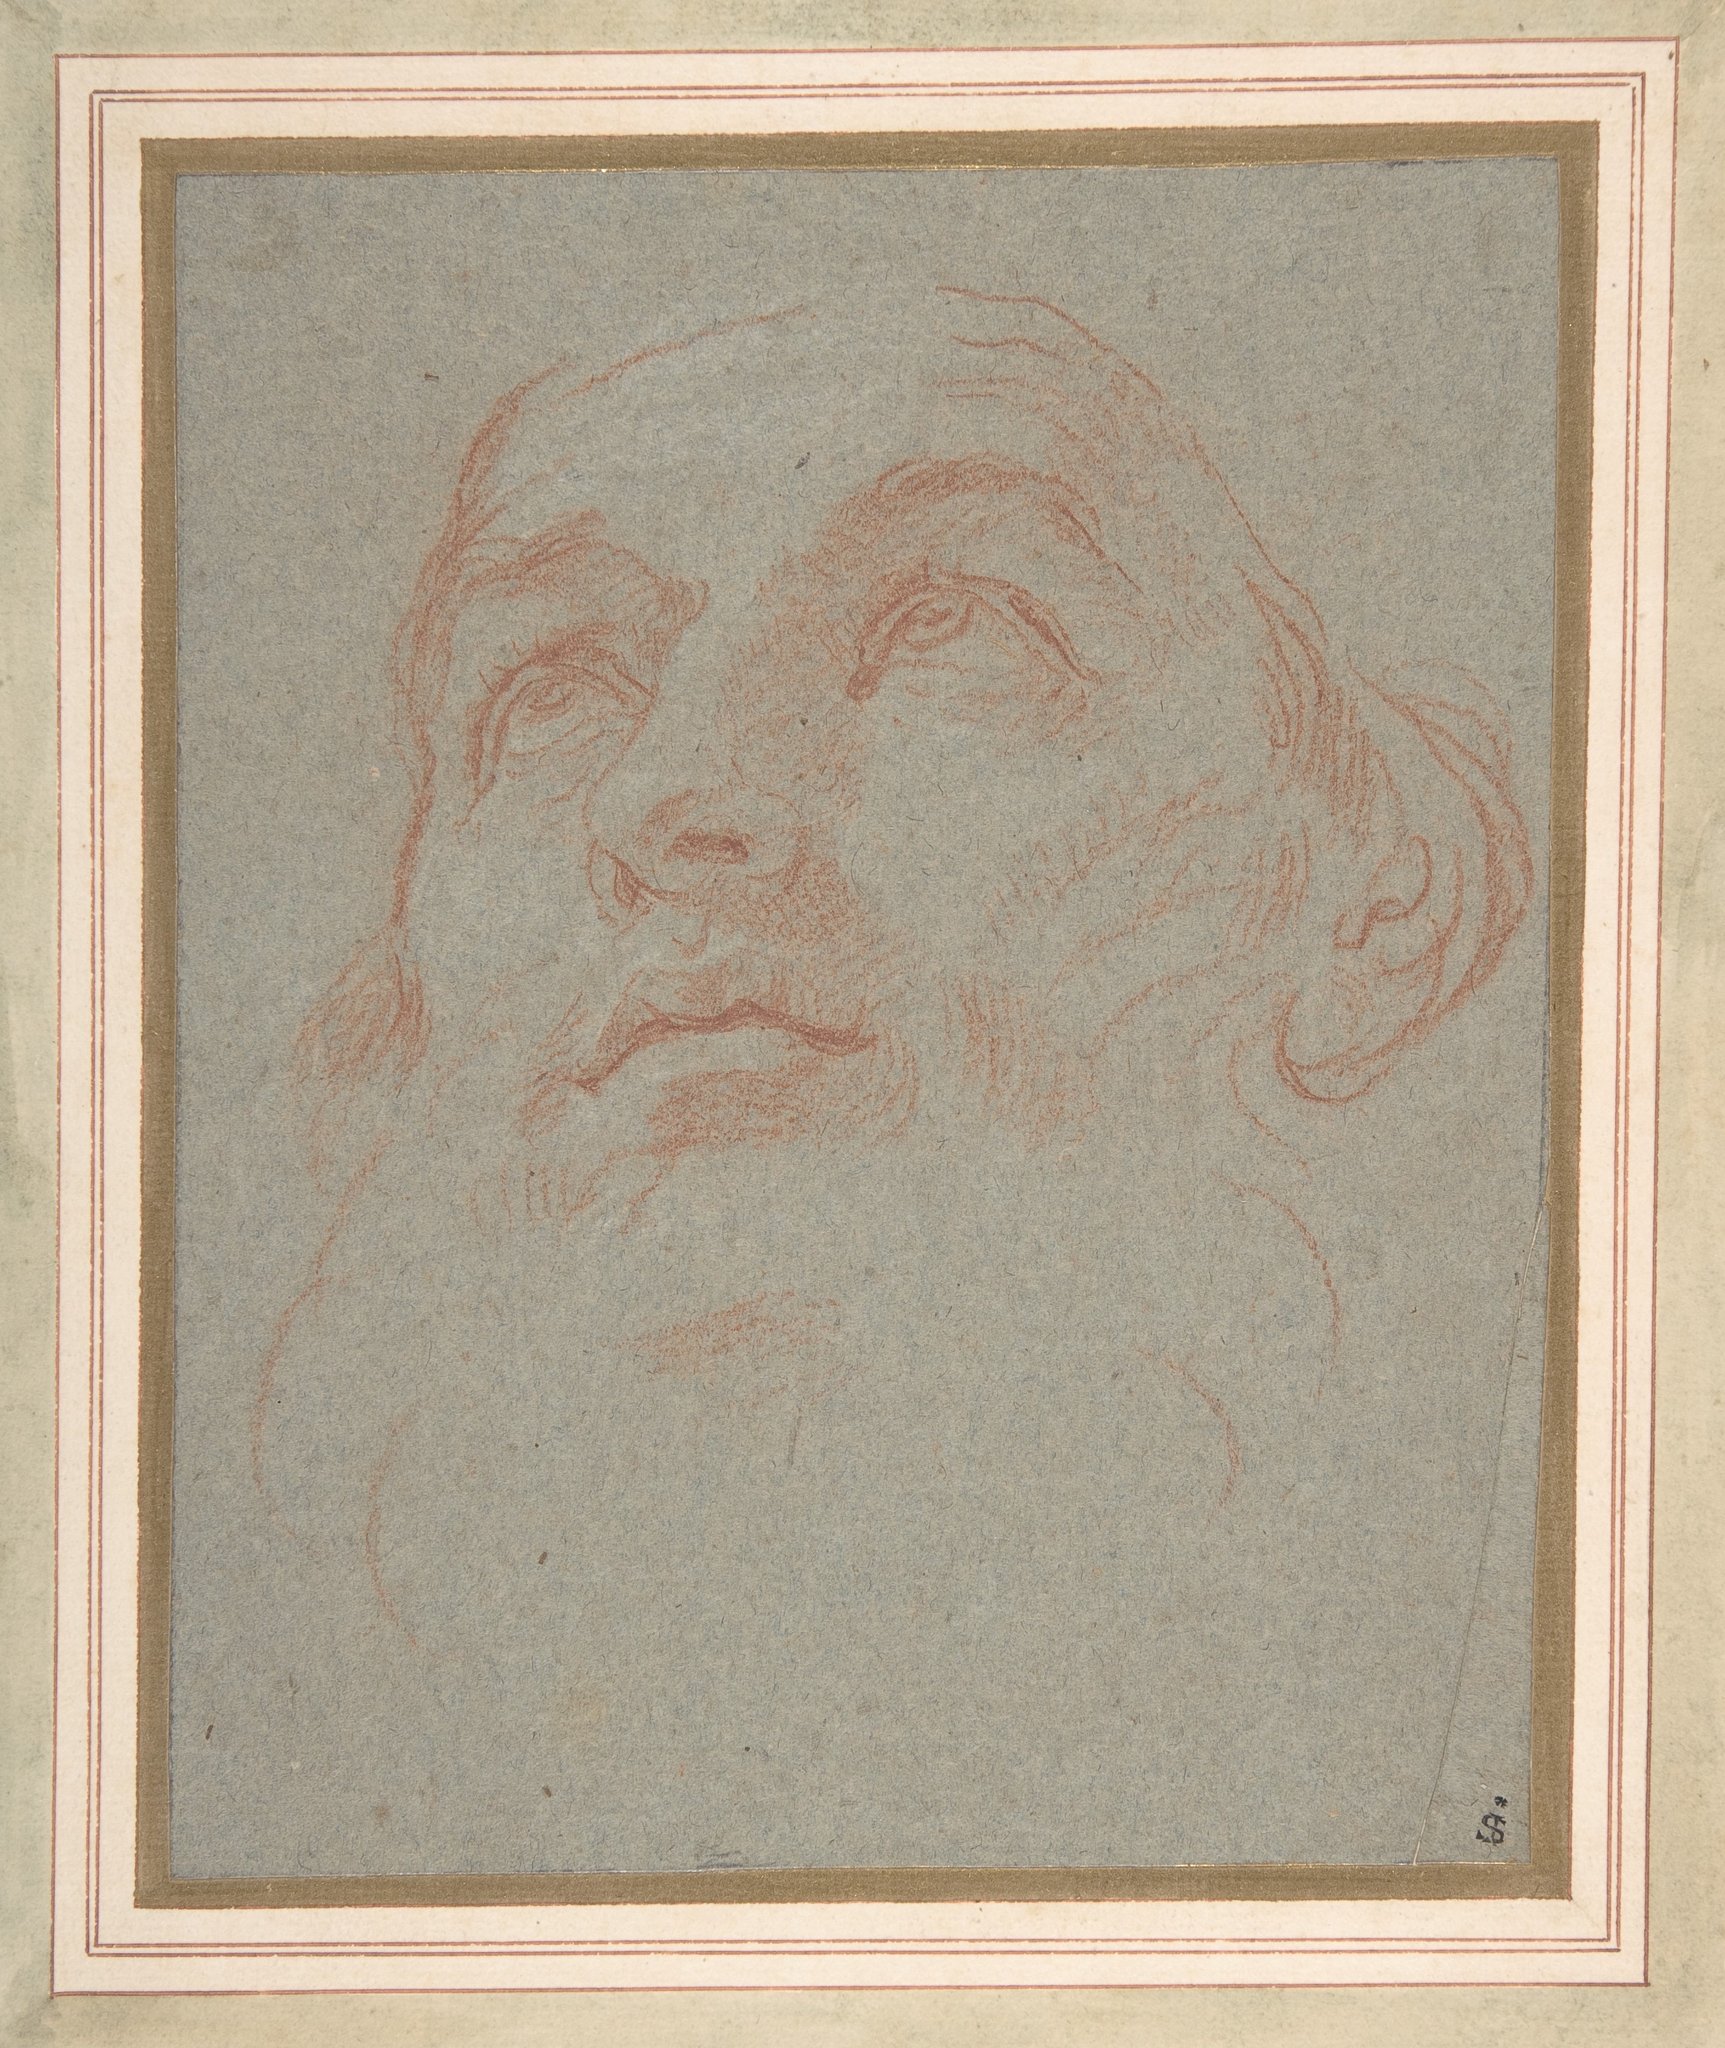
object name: drawing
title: Head of a Bearded Man Looking to Upper Left (Saint Ambrose)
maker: carlo maratti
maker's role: artist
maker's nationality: italian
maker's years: 1625-1713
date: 1625-1713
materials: chalk, paper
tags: heads,men